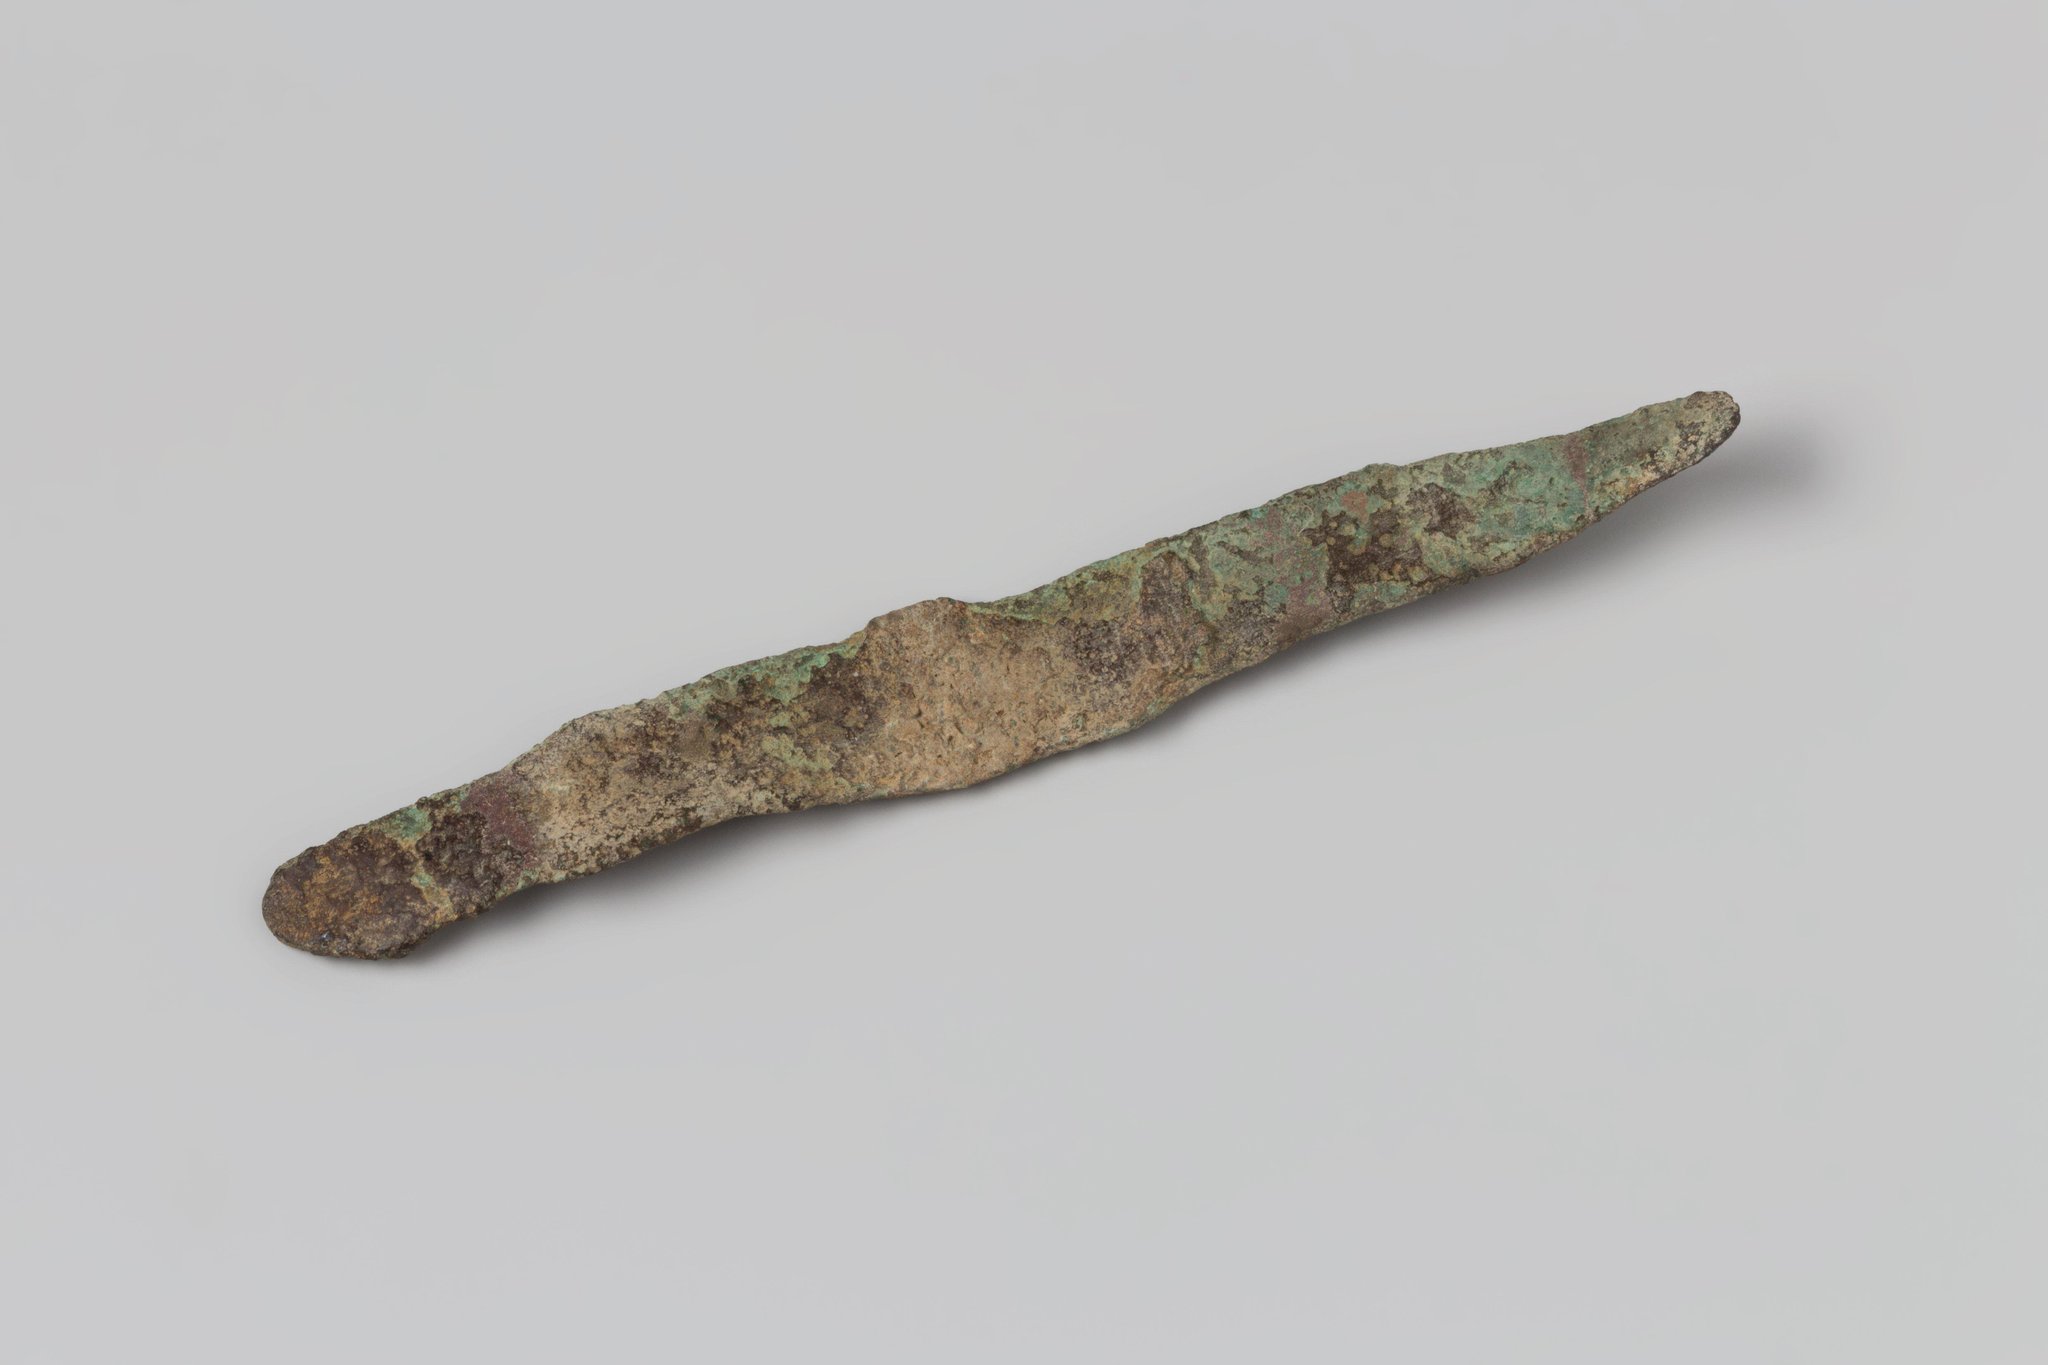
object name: scheepswrakvondst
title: Fragment van koper uit het wrak van de Oost-Indiëvaarder Hollandia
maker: Anonymous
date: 1700-1743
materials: copper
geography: netherlands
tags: verenigde oostindische compagnie, hollandia (schip), annet